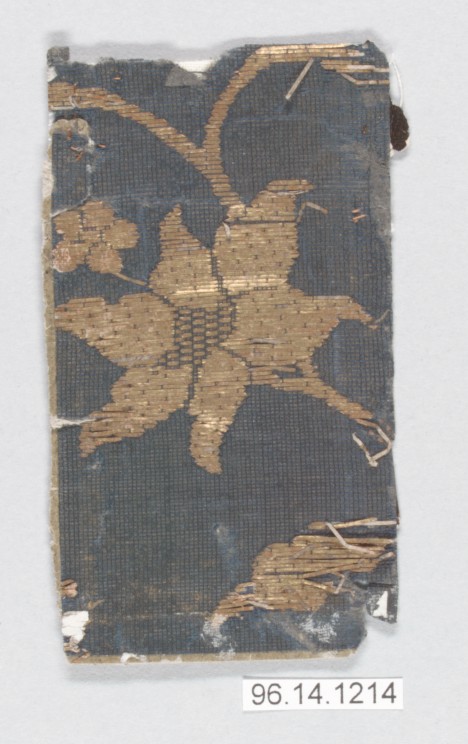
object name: piece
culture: japanese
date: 1101-1400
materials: silk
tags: flowers